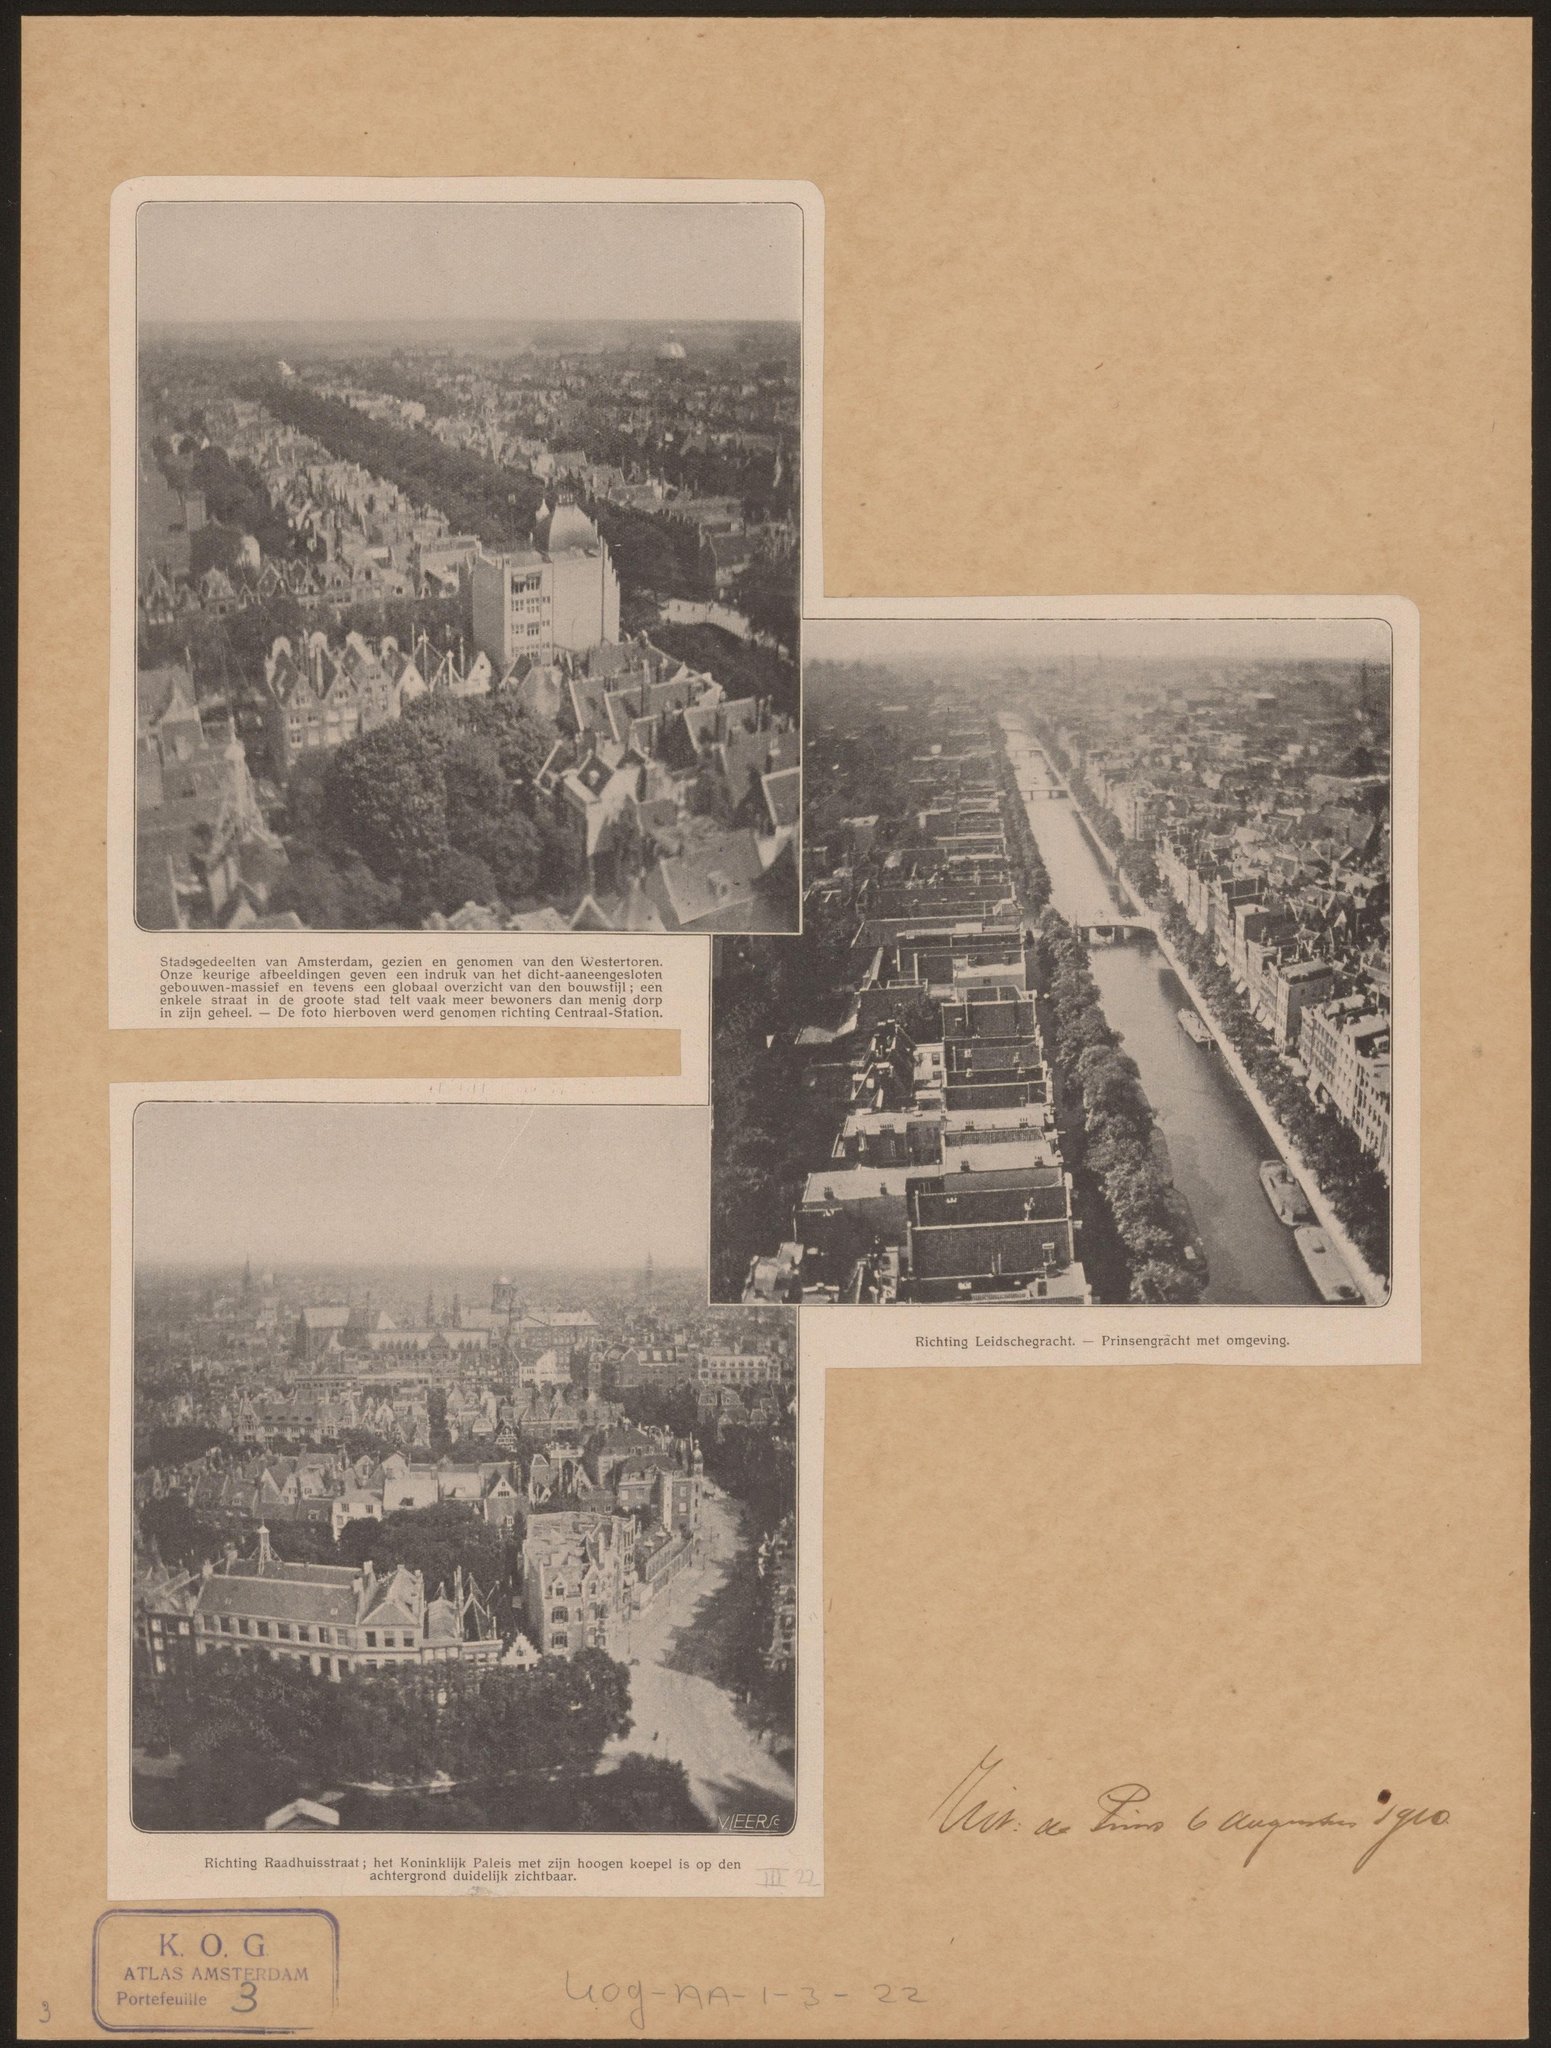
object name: photomechanical print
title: Gezichten vanuit de Westertoren, gezien naar het Station Amsterdam Centraal, de Leidsegracht en de Raadhuisstraat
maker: Anonymous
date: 1910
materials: paper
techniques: letterpress printing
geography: amsterdam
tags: prison, jail, canal, prospect of city, town panorama, silhouette of city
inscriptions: collector's mark: ‘3’ Lugt 1641b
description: Onderwerpsrubriek binnen de Atlas Amsterdam: Panorama's en verzamelprenten.